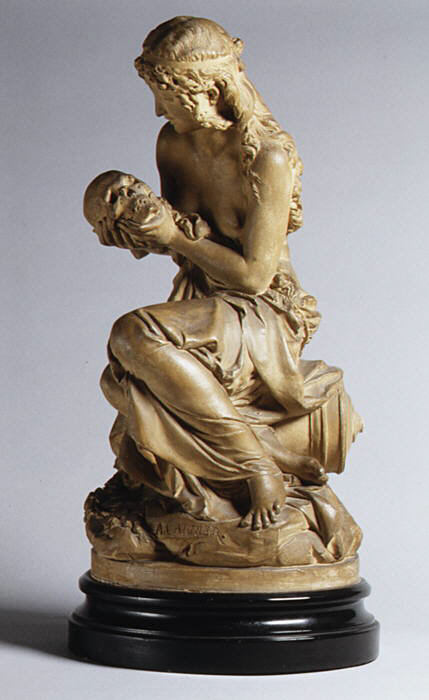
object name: statuette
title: Allegory of War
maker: albert-ernest carrier-belleuse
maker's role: artist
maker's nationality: french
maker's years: 1824-1887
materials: paint, terracotta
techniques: casting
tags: skulls,women